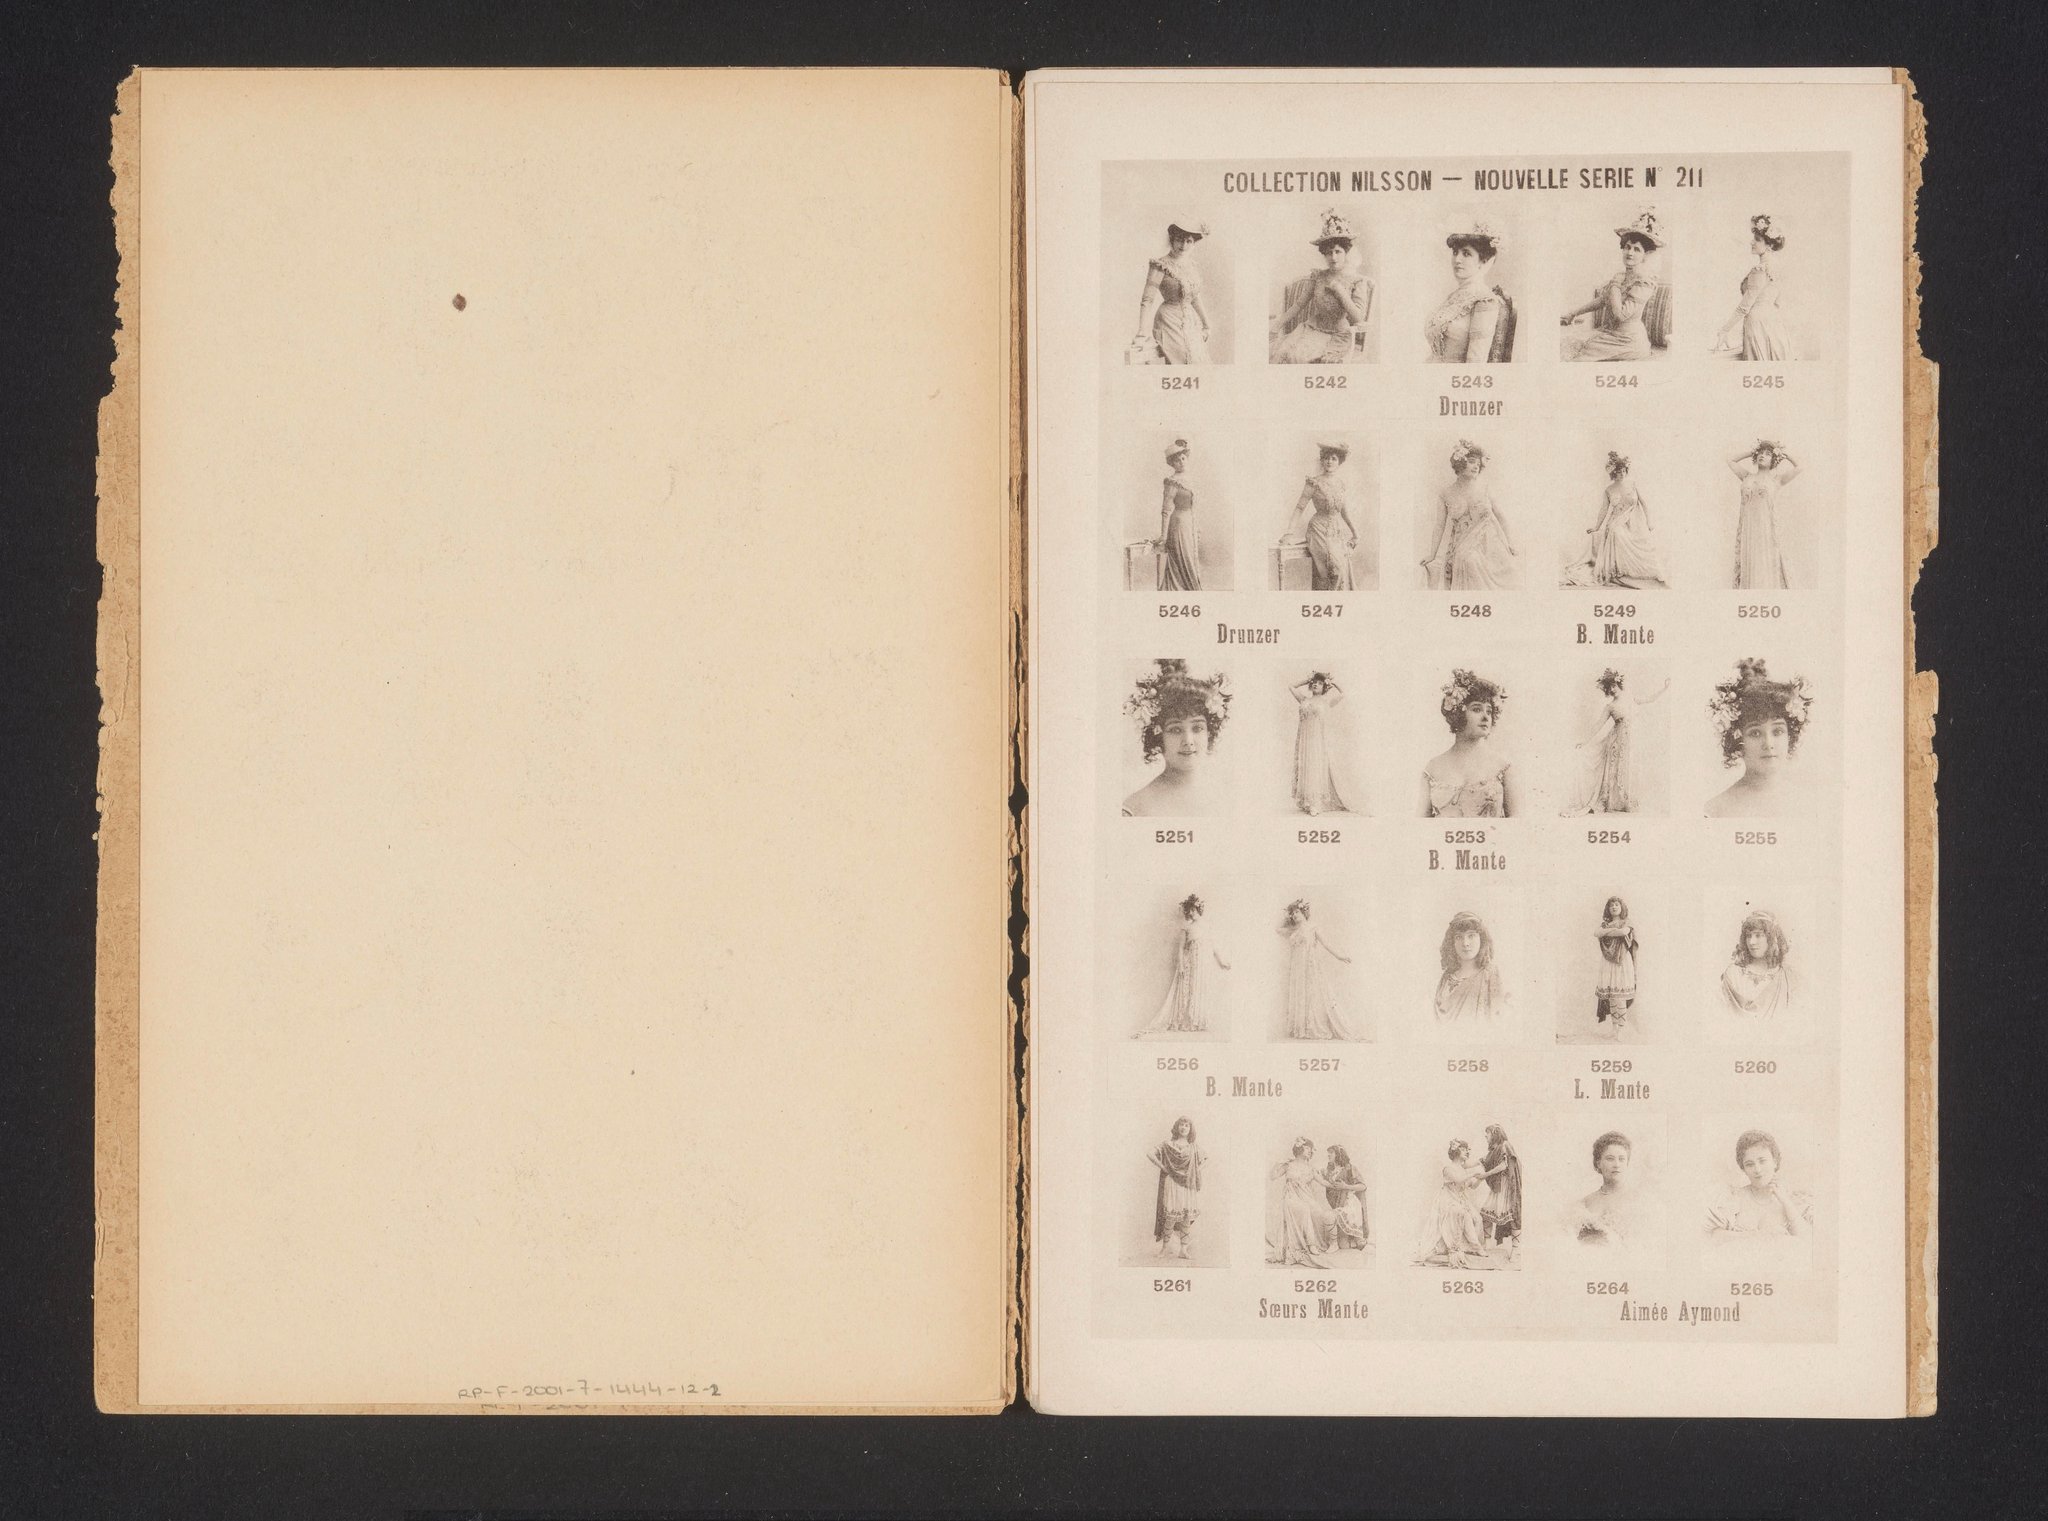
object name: page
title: Collection Nilsson - Nouvelle Série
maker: Anonymous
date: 1894-1899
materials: paper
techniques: photograph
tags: historical persons - bb - woman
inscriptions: number: ‘No 211’